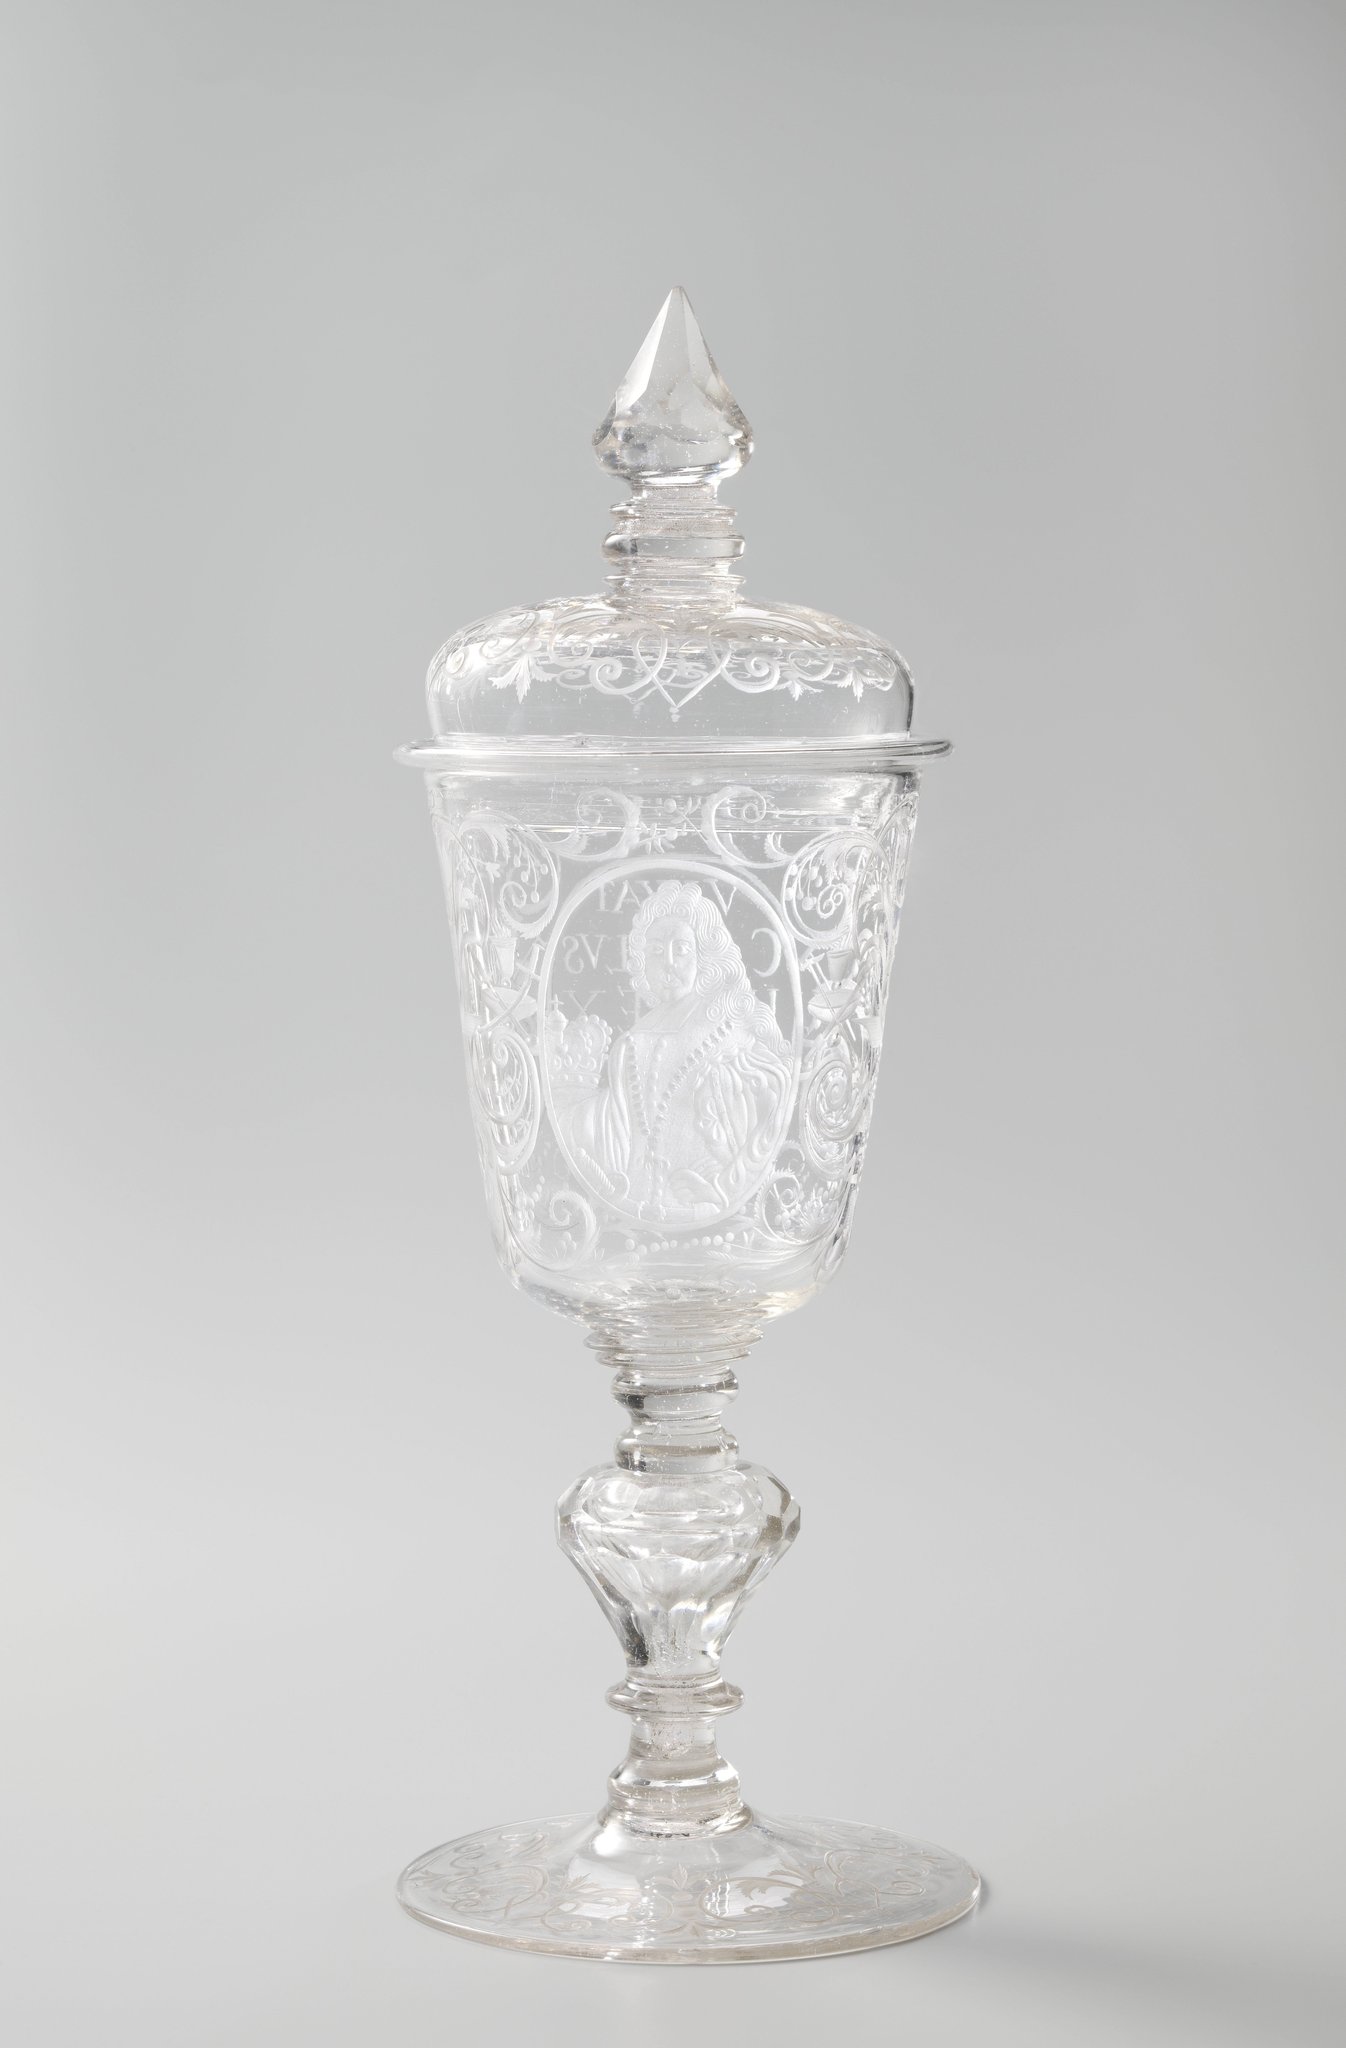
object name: goblet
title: Lidded wine glass with a portrait of Charles VI of Habsburg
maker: Anonymous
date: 1712-1714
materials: glass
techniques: glassblowing, grinding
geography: bohemia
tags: vienna, charles vi (holy roman emperor), historical persons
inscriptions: signature and date: ‘Jacob Sang, inv: et Fec: Amsterdam 1760.’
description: translation of inscription: Long Live Charles III, King of Spain